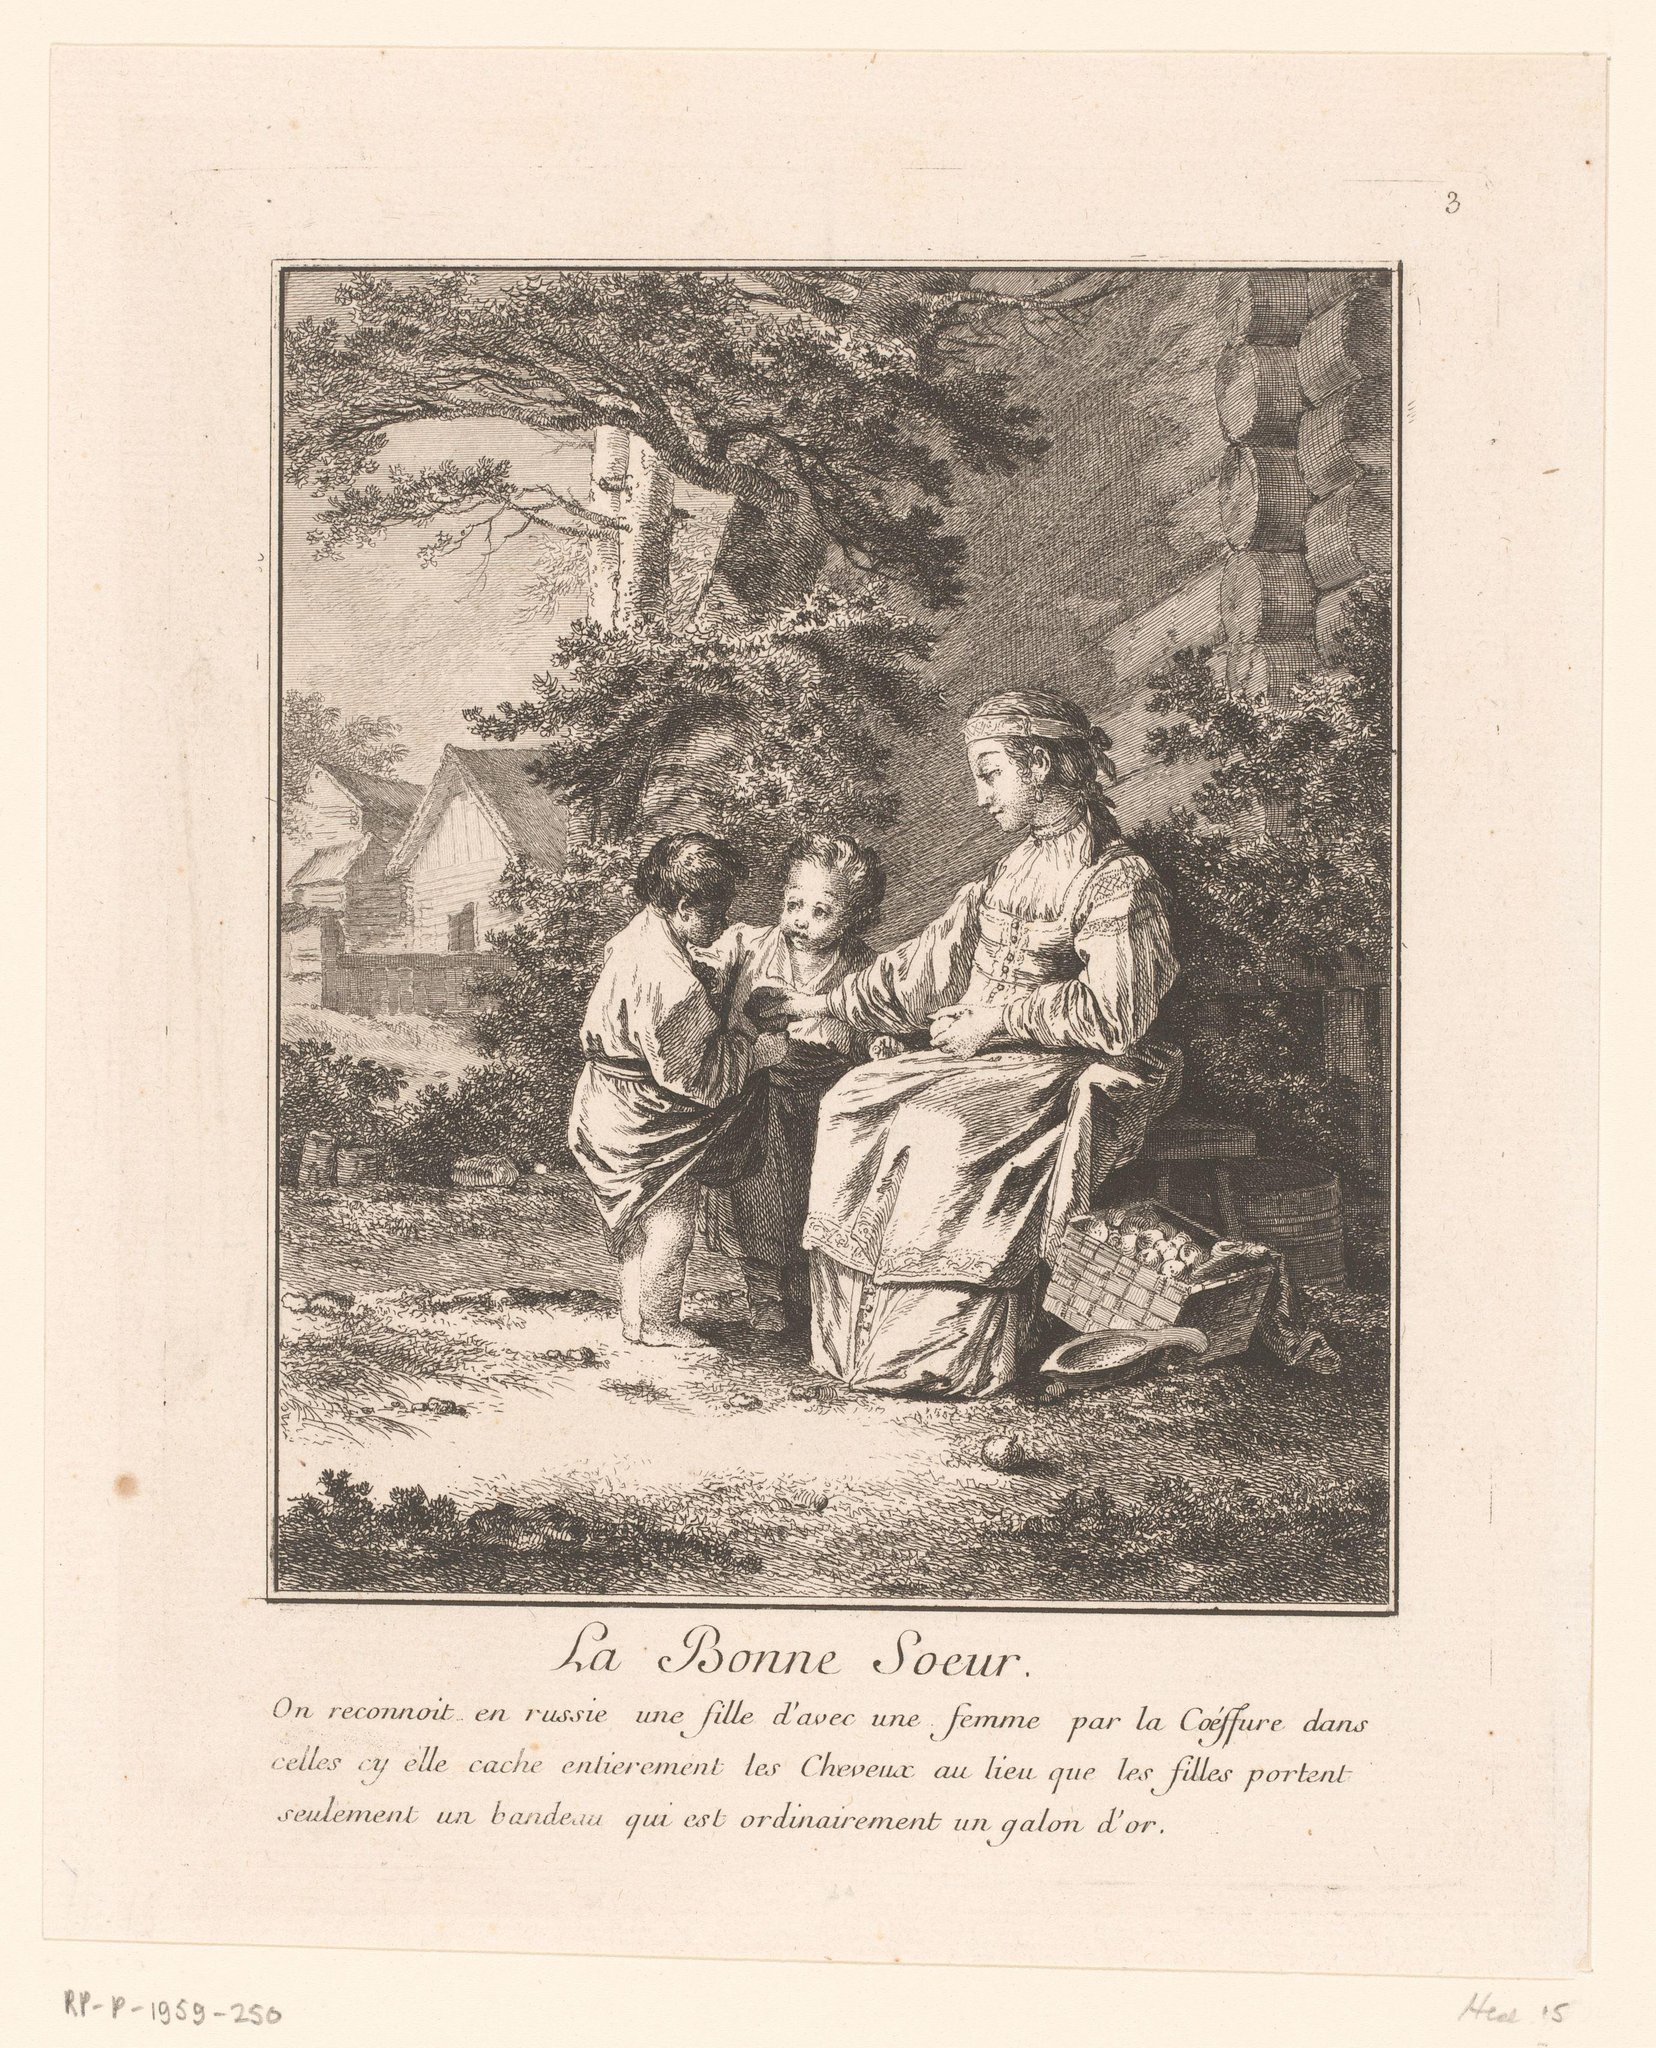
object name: print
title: Russische tradities en gebruiken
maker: jean baptist leprince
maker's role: draughtsman, print maker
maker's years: 1734-1781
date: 1744-1781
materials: paper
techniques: etching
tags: giving food, folk costume, regional costume, brothers or sisters (second degree family relationships)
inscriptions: collector's mark: Lugt 2228, collector's mark: Lugt 2760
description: Maakt deel uit van een tiendelige serie met Russische tradities en gebruiken.